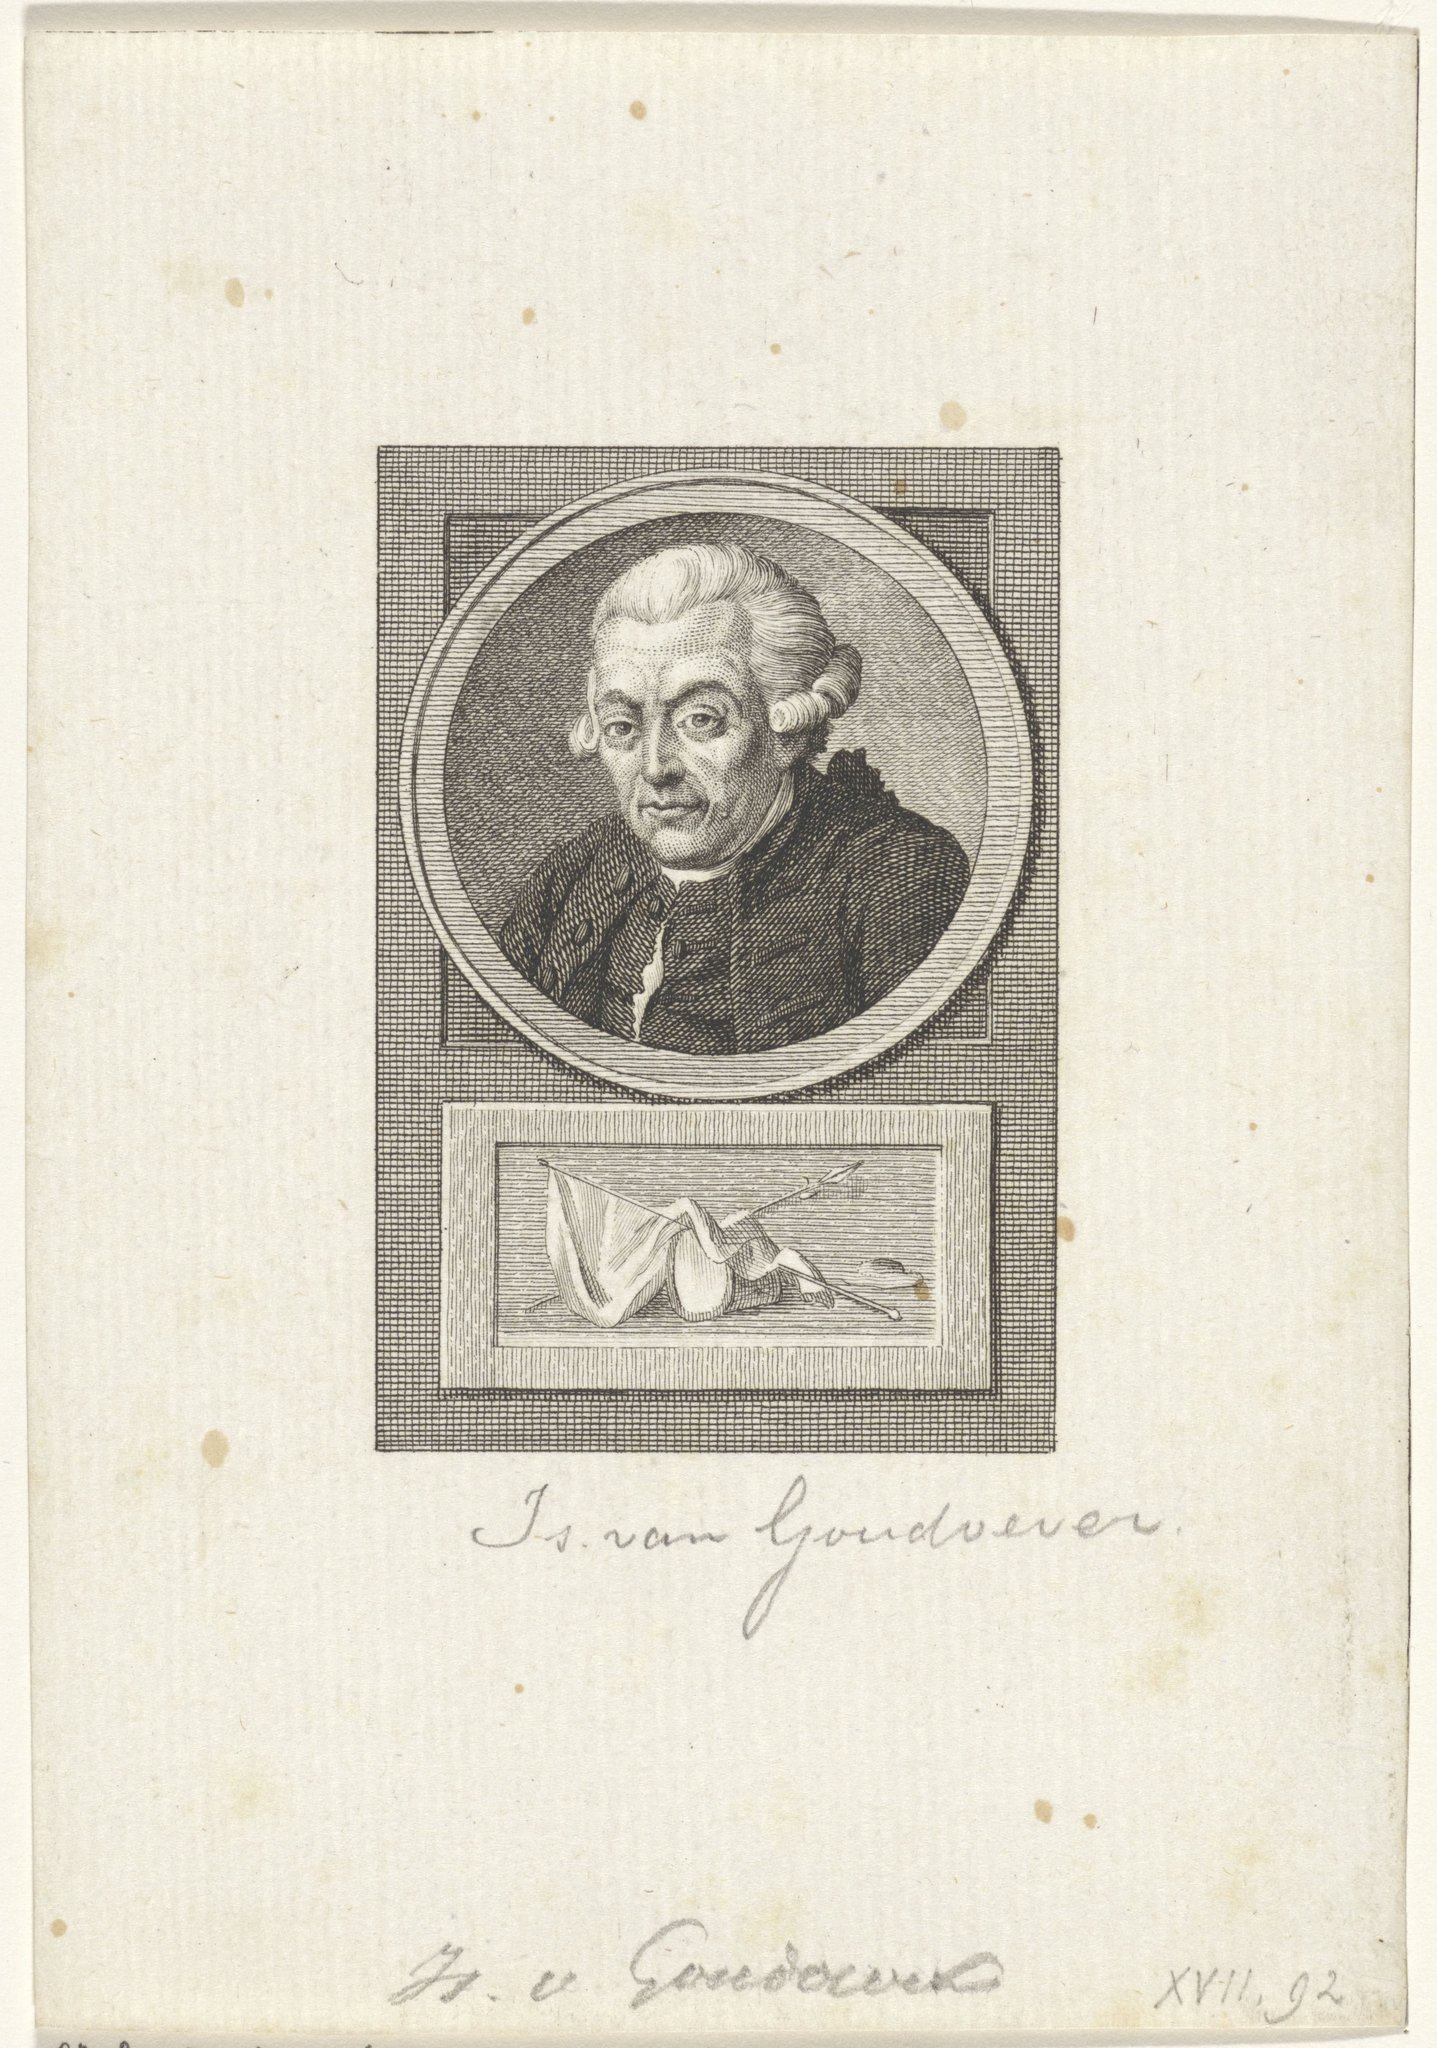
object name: print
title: Portret van Isaak van Goudoever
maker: reinier vinkeles (i)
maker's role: draughtsman, print maker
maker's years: 1741-1816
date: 1783-1795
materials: paper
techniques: engraving, etching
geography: amsterdam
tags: drum (musical instrument), (military) flags and standards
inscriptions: collector's mark: Lugt 2228, inscription: ‘Is. van Goudoever XVII, 92’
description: Latere staat prent gebruikt in: Fokke, Jan. Geschiedenissen der Vereenigde Nederlanden voor de vaderlandsche jeugd Ie-XXVste deel. Amsterdam: Johannes Allart, 1783-1795. Deel XVII. Vergelijk: C.J. de Bruyn Kops, 'Een portret van Egbert van Drielst, geschilderd door Jan Ekels de Jonge', Bulletin van het Rijksmuseum 16 (1968), p. 65, afb. 6.